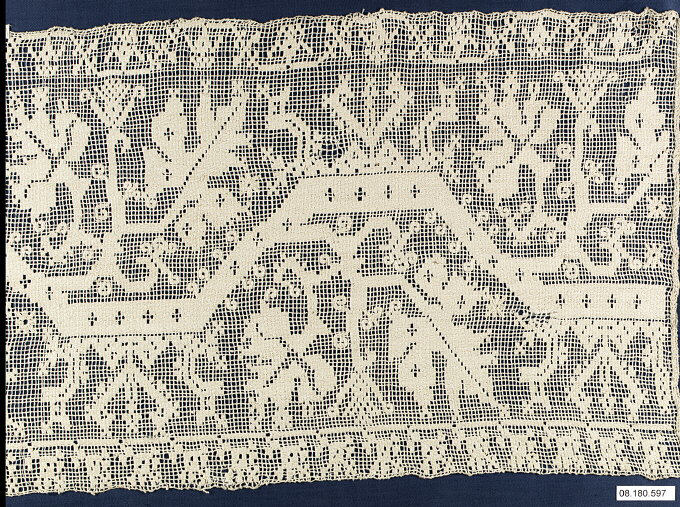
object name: border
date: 1501-1600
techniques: embroidery